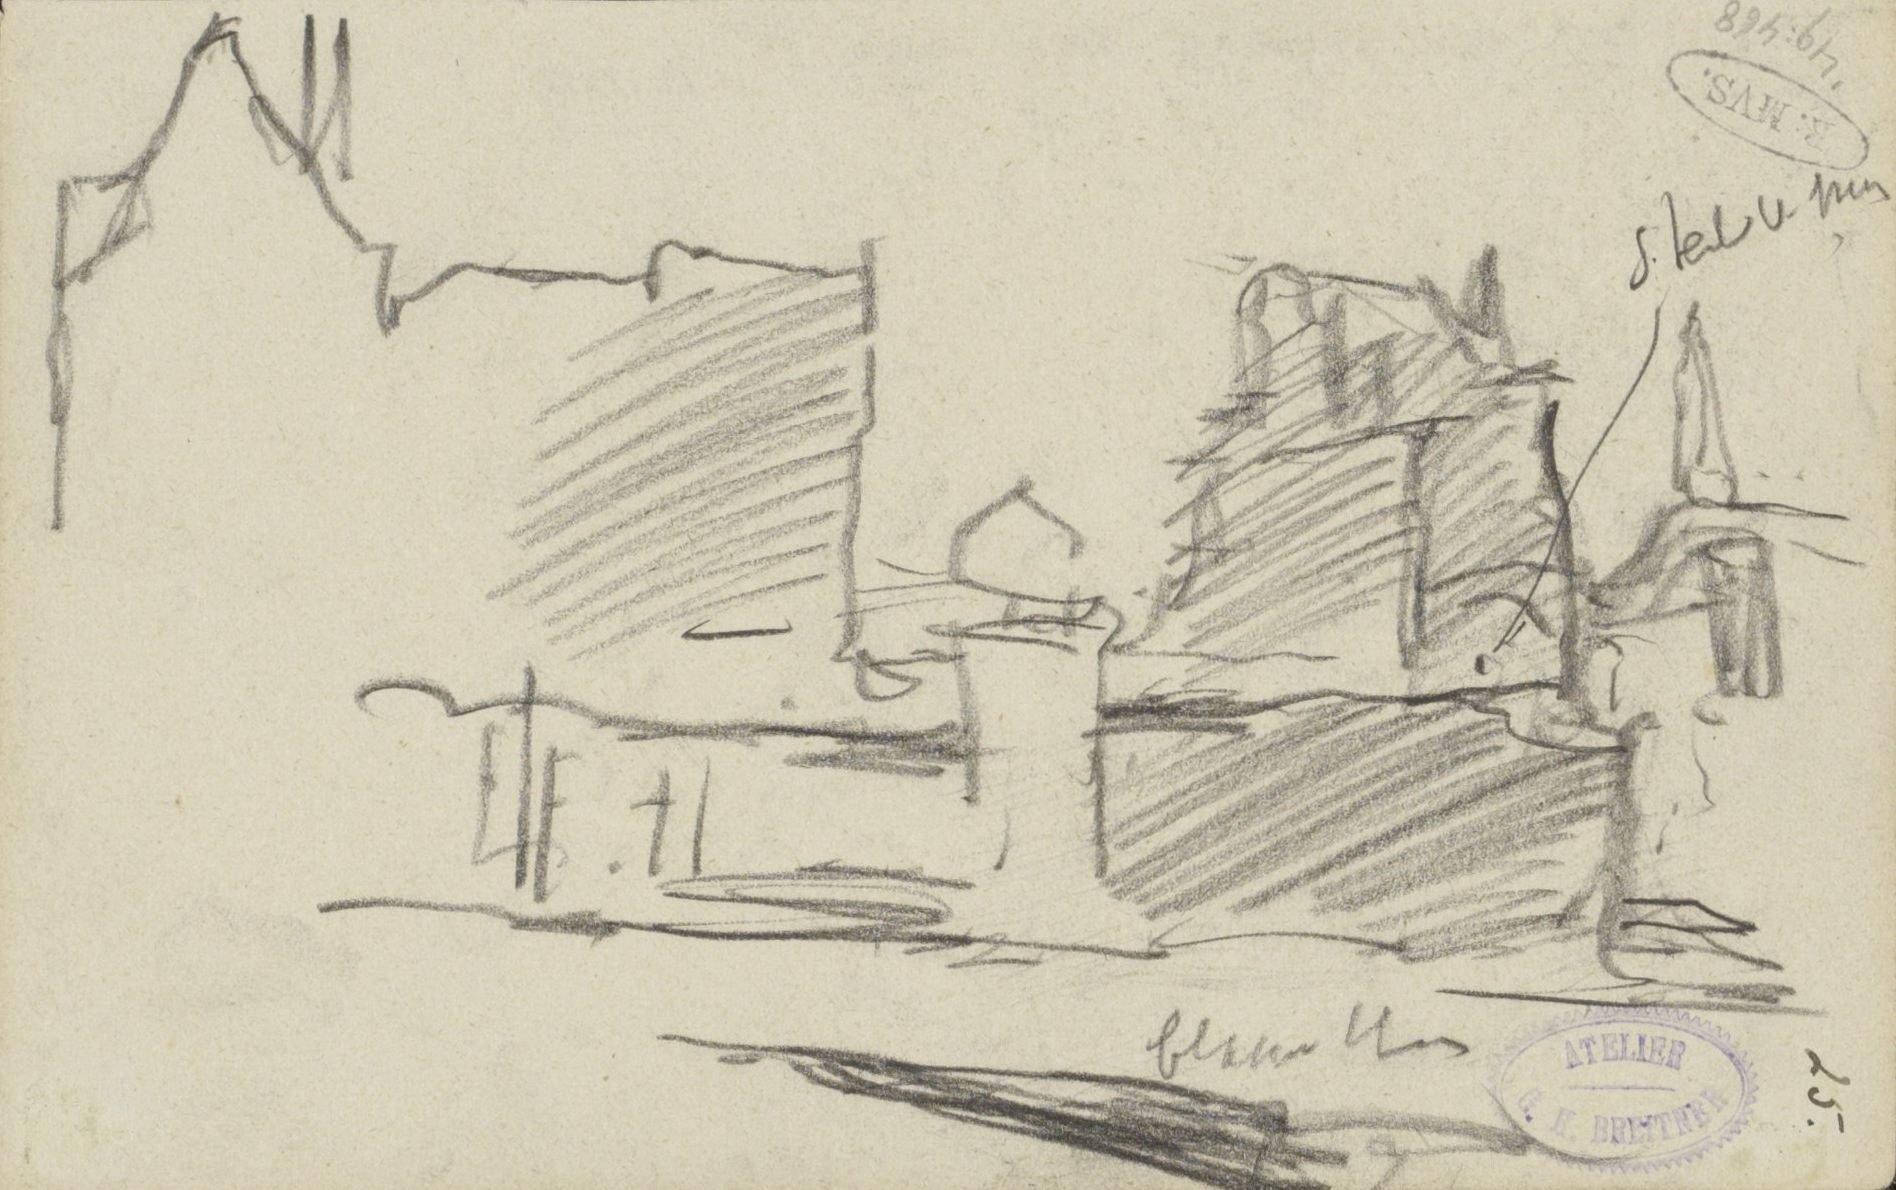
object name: drawing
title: Gezicht in Amsterdam, mogelijk het Beurspleintje tijdens de afbraak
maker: george hendrik breitner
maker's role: draughtsman, painter, print maker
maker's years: 1857-1923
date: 1912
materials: chalk, paper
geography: amsterdam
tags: square, place, circus, etc., civic architecture; edifices; dwellings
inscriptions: collector's mark: Lugt 2228, workshop stamp: Lugt 291d